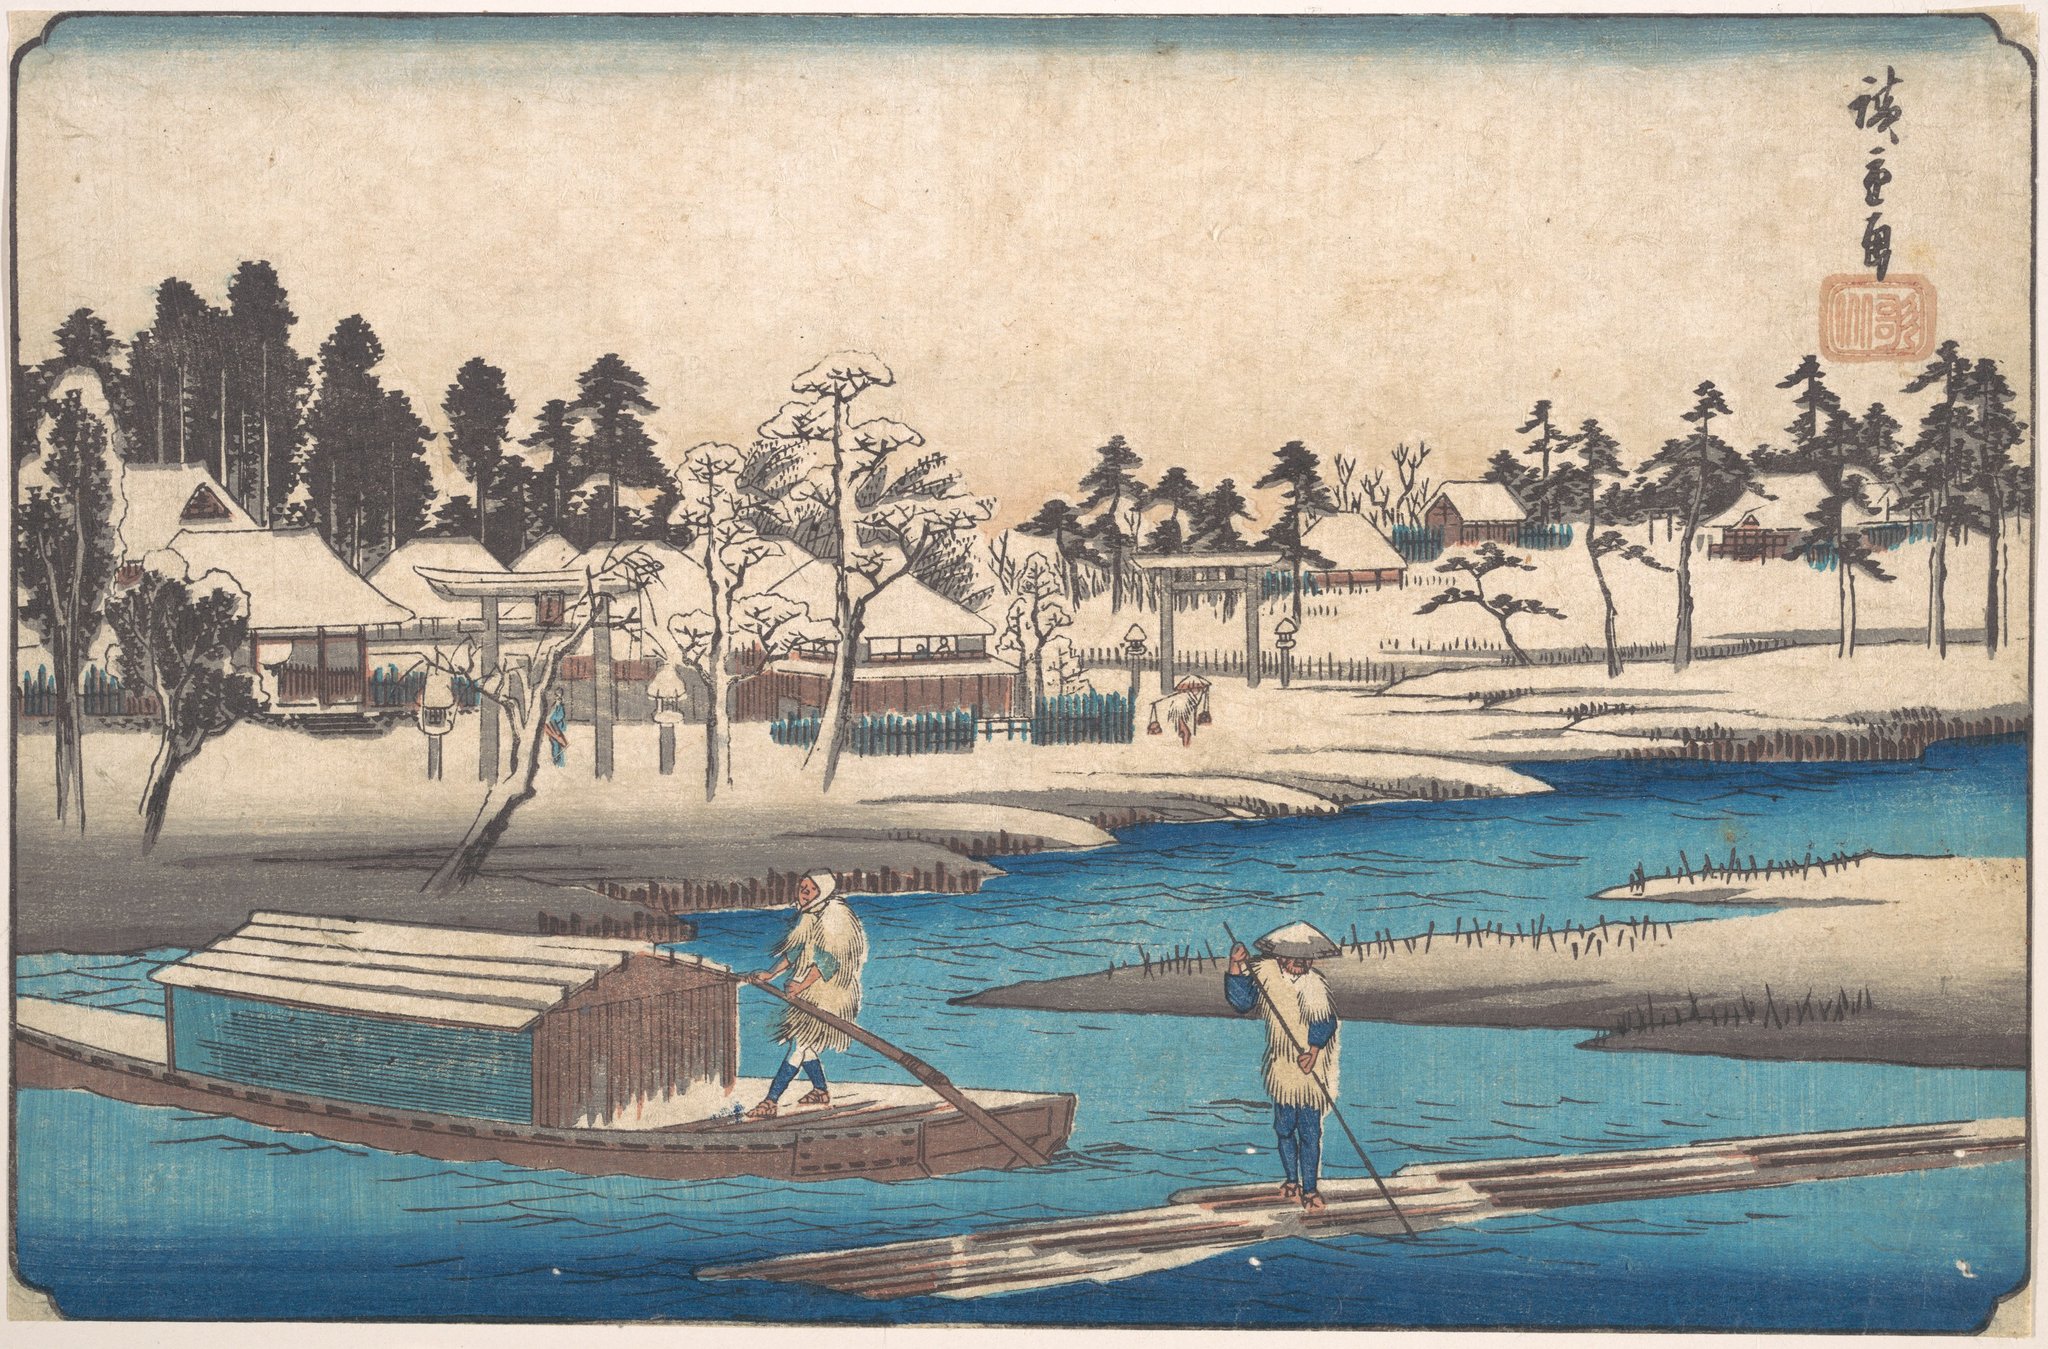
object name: print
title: Clearing Weather after Snow at Massaki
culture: japanese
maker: utagawa hiroshige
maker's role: artist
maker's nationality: japanese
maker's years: 1797-1858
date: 1797-1858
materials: ink, paper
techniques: woodblock print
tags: trees,snow,boats